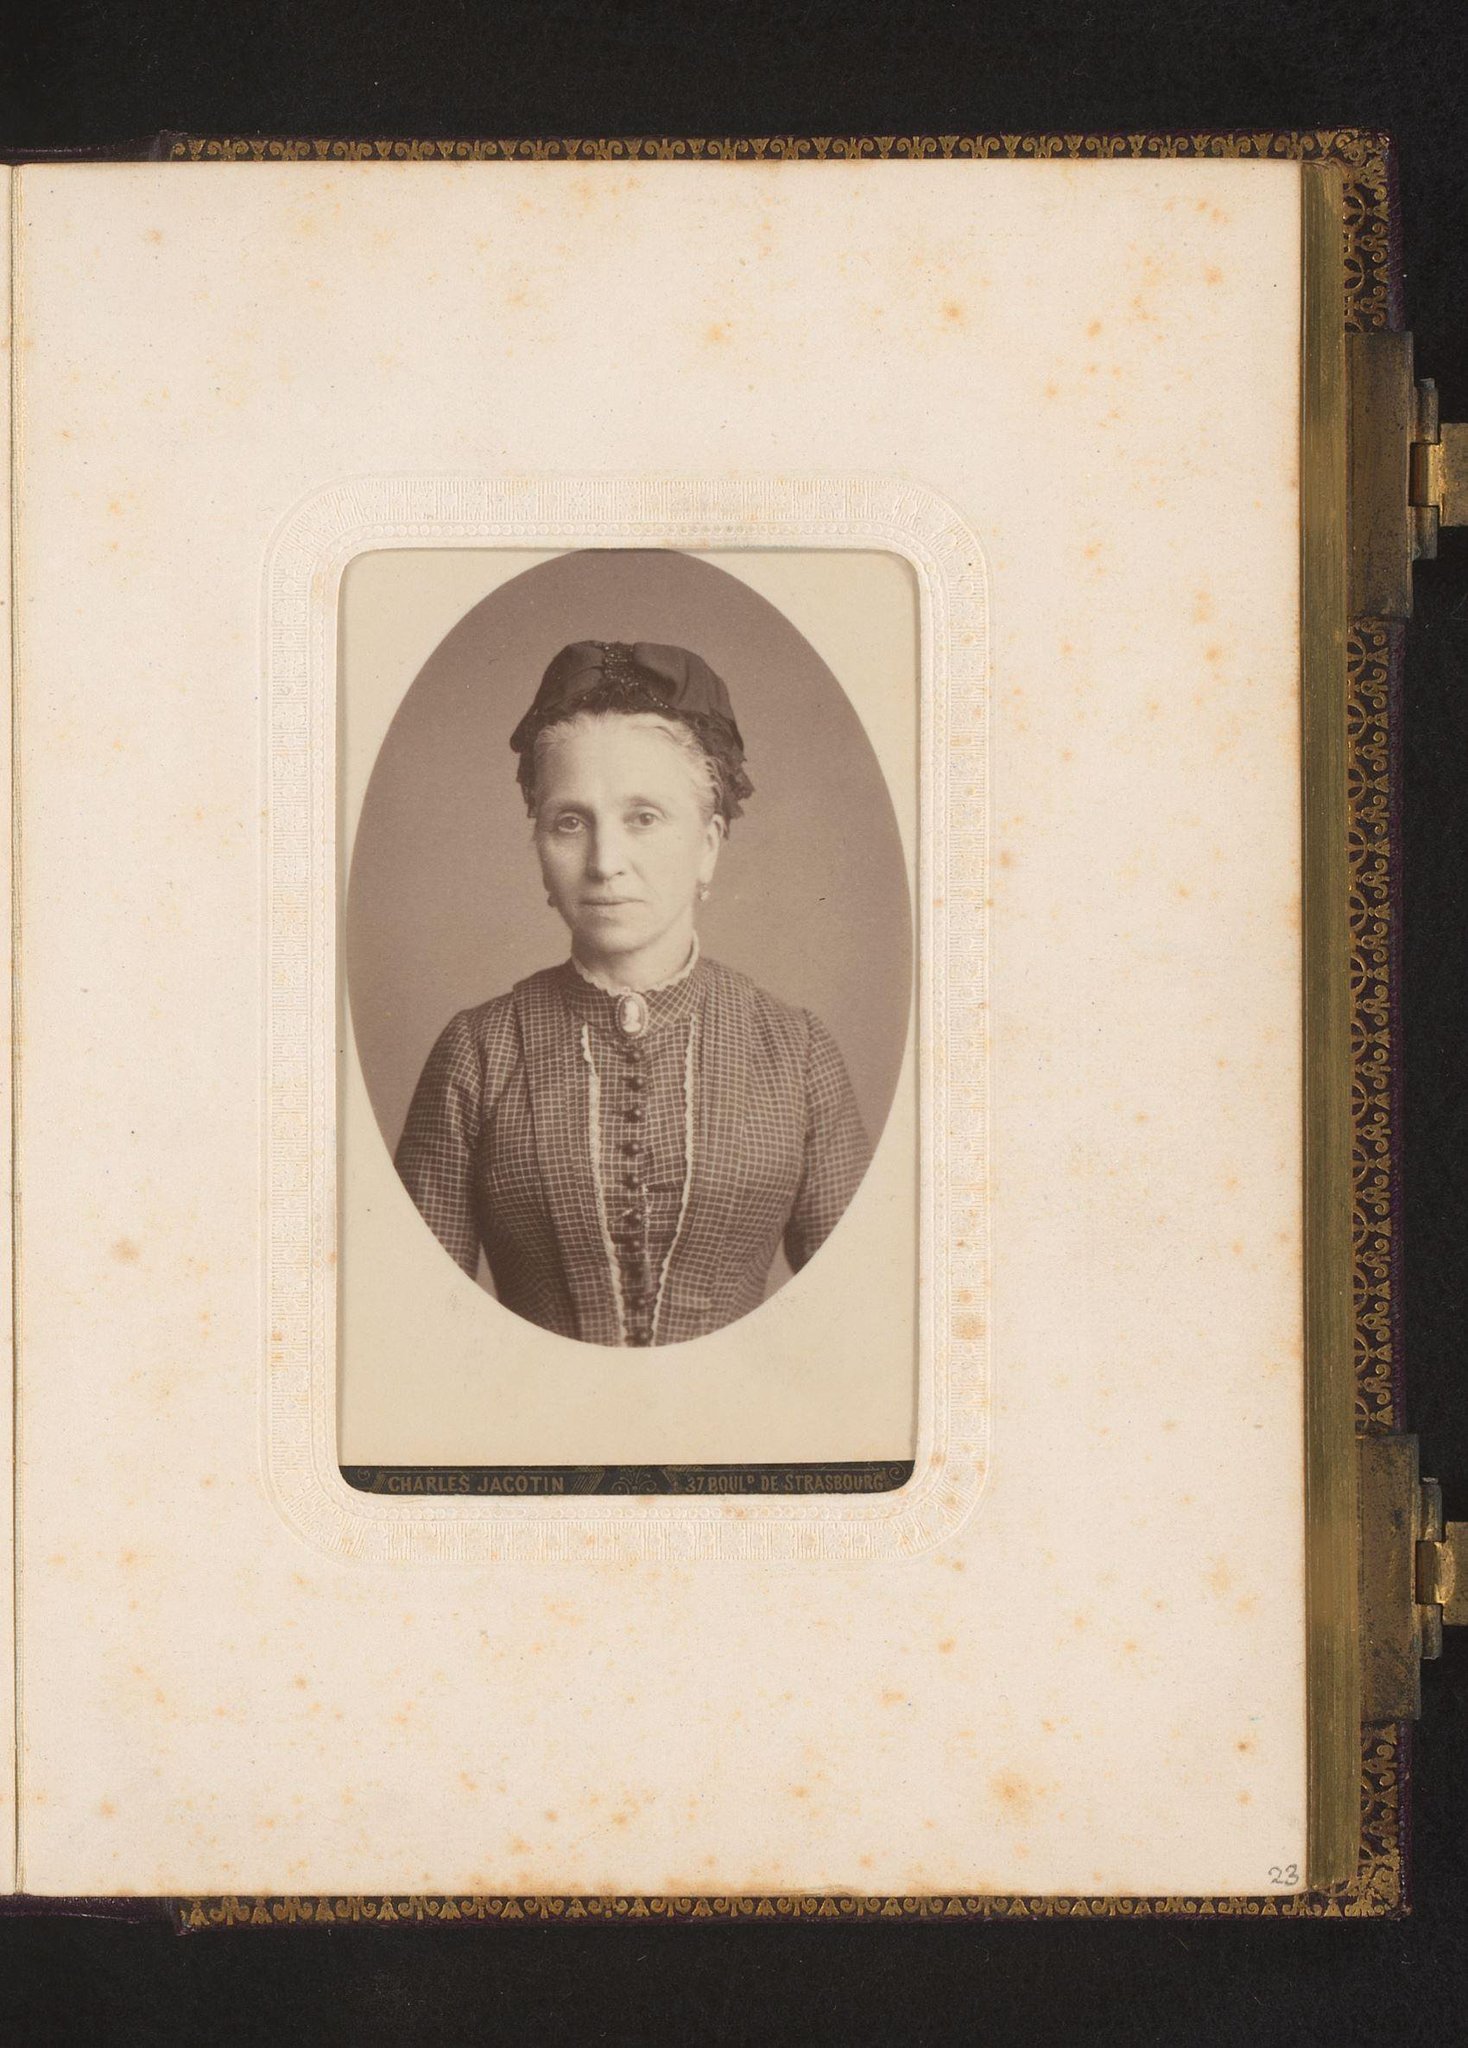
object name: photograph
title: Portret van een vrouw met muts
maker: charles jacotin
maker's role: fotograaf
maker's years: 1863-1895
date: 1863-1895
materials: cardboard, celluloid, photographic support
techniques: albumen print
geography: paris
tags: historical persons - bb - woman, head-gear: cap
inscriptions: inscription: ‘Photographie/ CH. JACOTIN/ 37, Bould de Strasbourg/ PARIS/ No..../ Il suffit de rappeler ce No/ pour avoir des cartes semblables.’